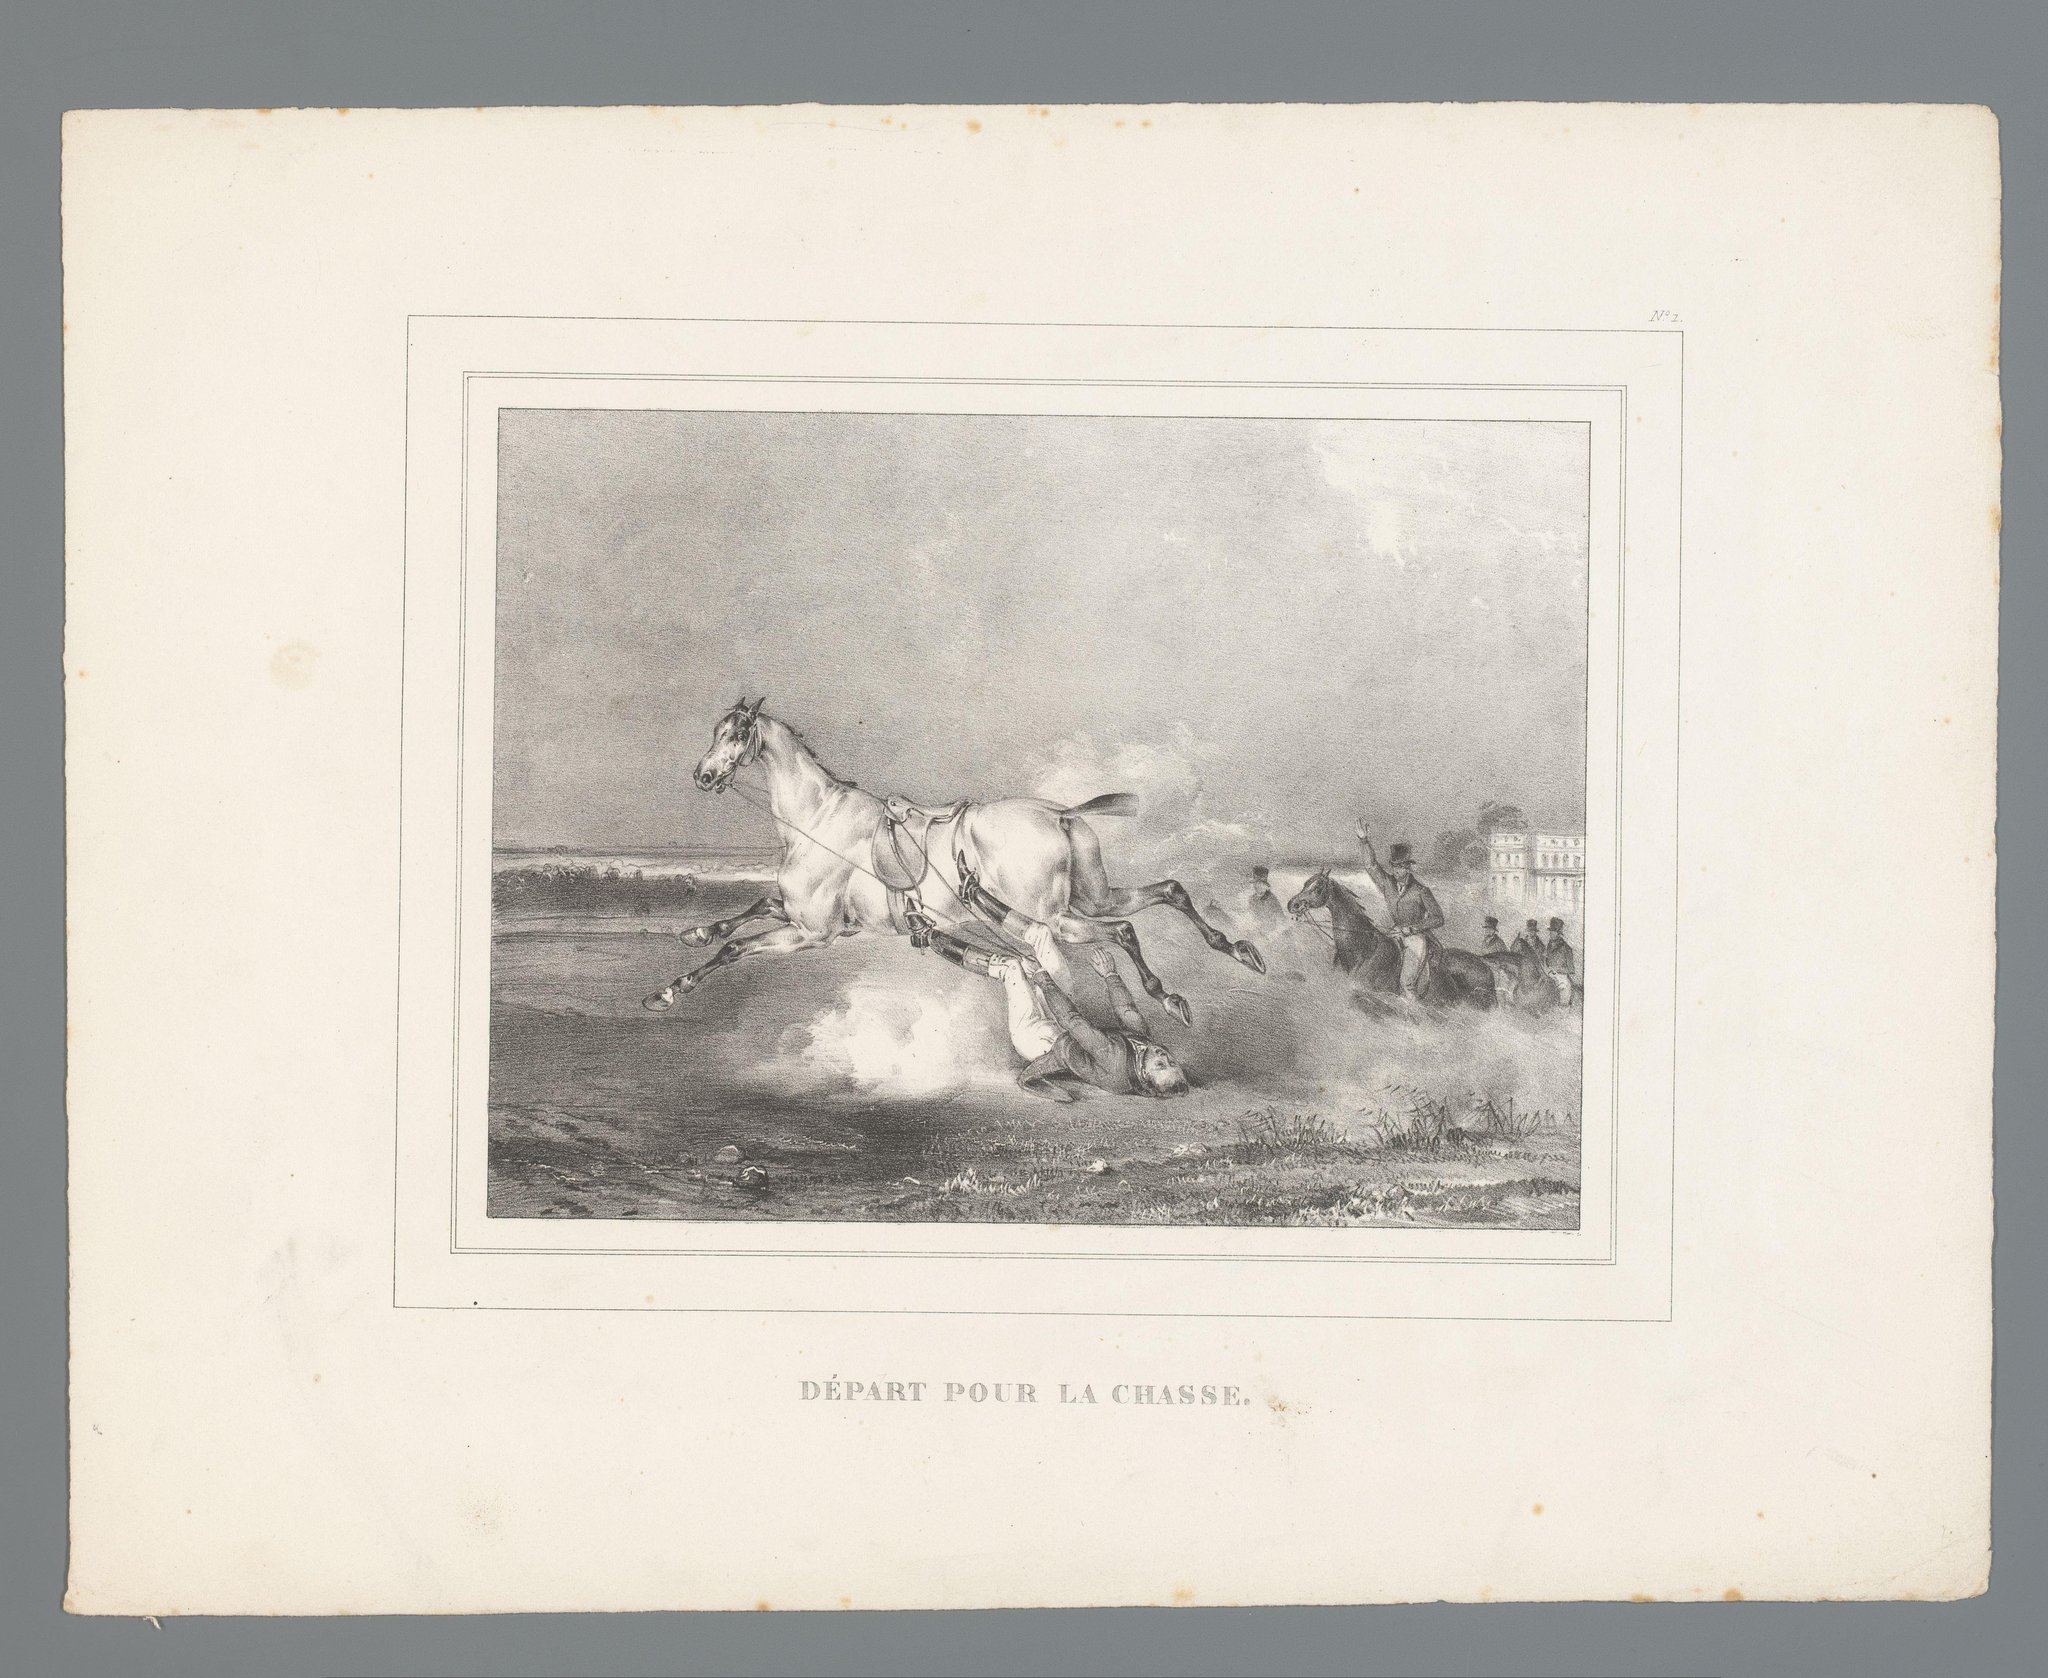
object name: print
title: Désagrémens de la chasse à courre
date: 1825-1827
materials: paper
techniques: lithograph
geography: brussels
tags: hunting, chase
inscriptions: collector's mark: Lugt 2228